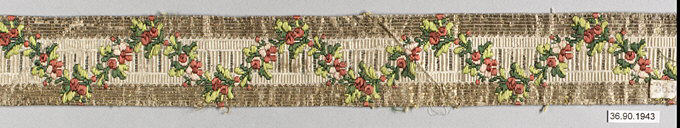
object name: galloon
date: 1701-1800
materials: silk